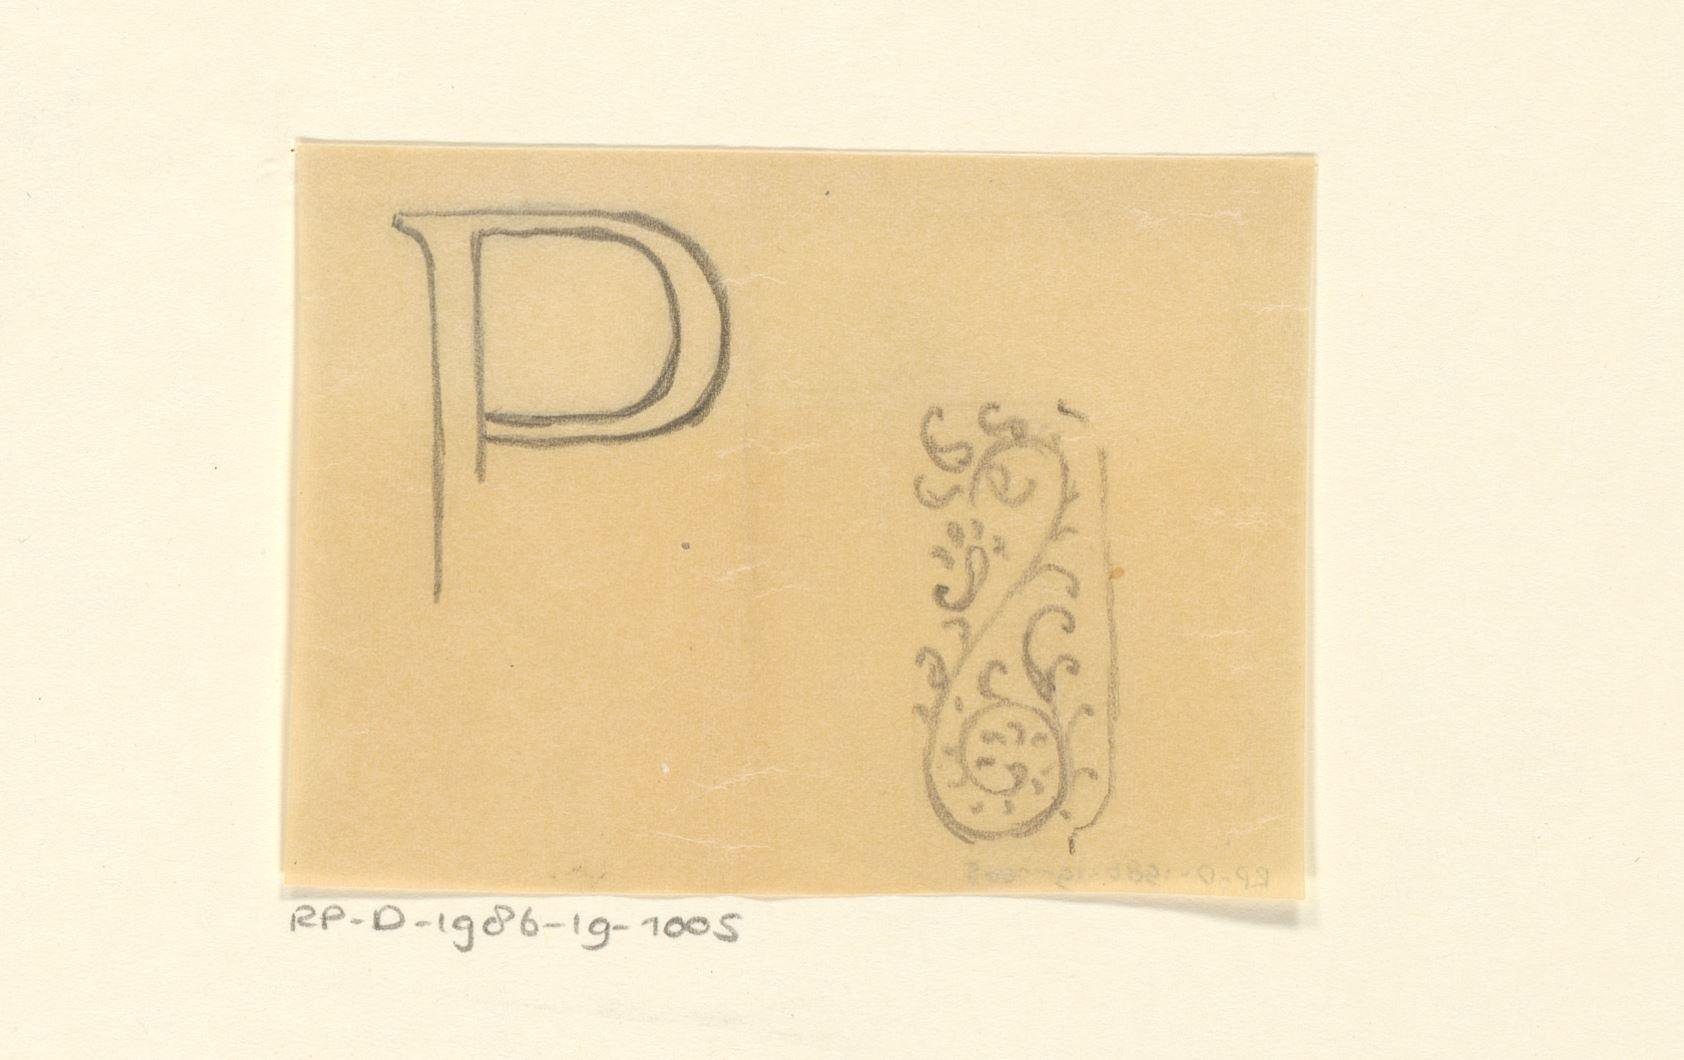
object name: design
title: Ontwerp voor een letter 'P' en een ornament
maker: reinier willem petrus de vries (1874-1953)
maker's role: draughtsman, print maker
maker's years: 1874-1953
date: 1884-1952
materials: pencil, paper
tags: letters, alphabet, script